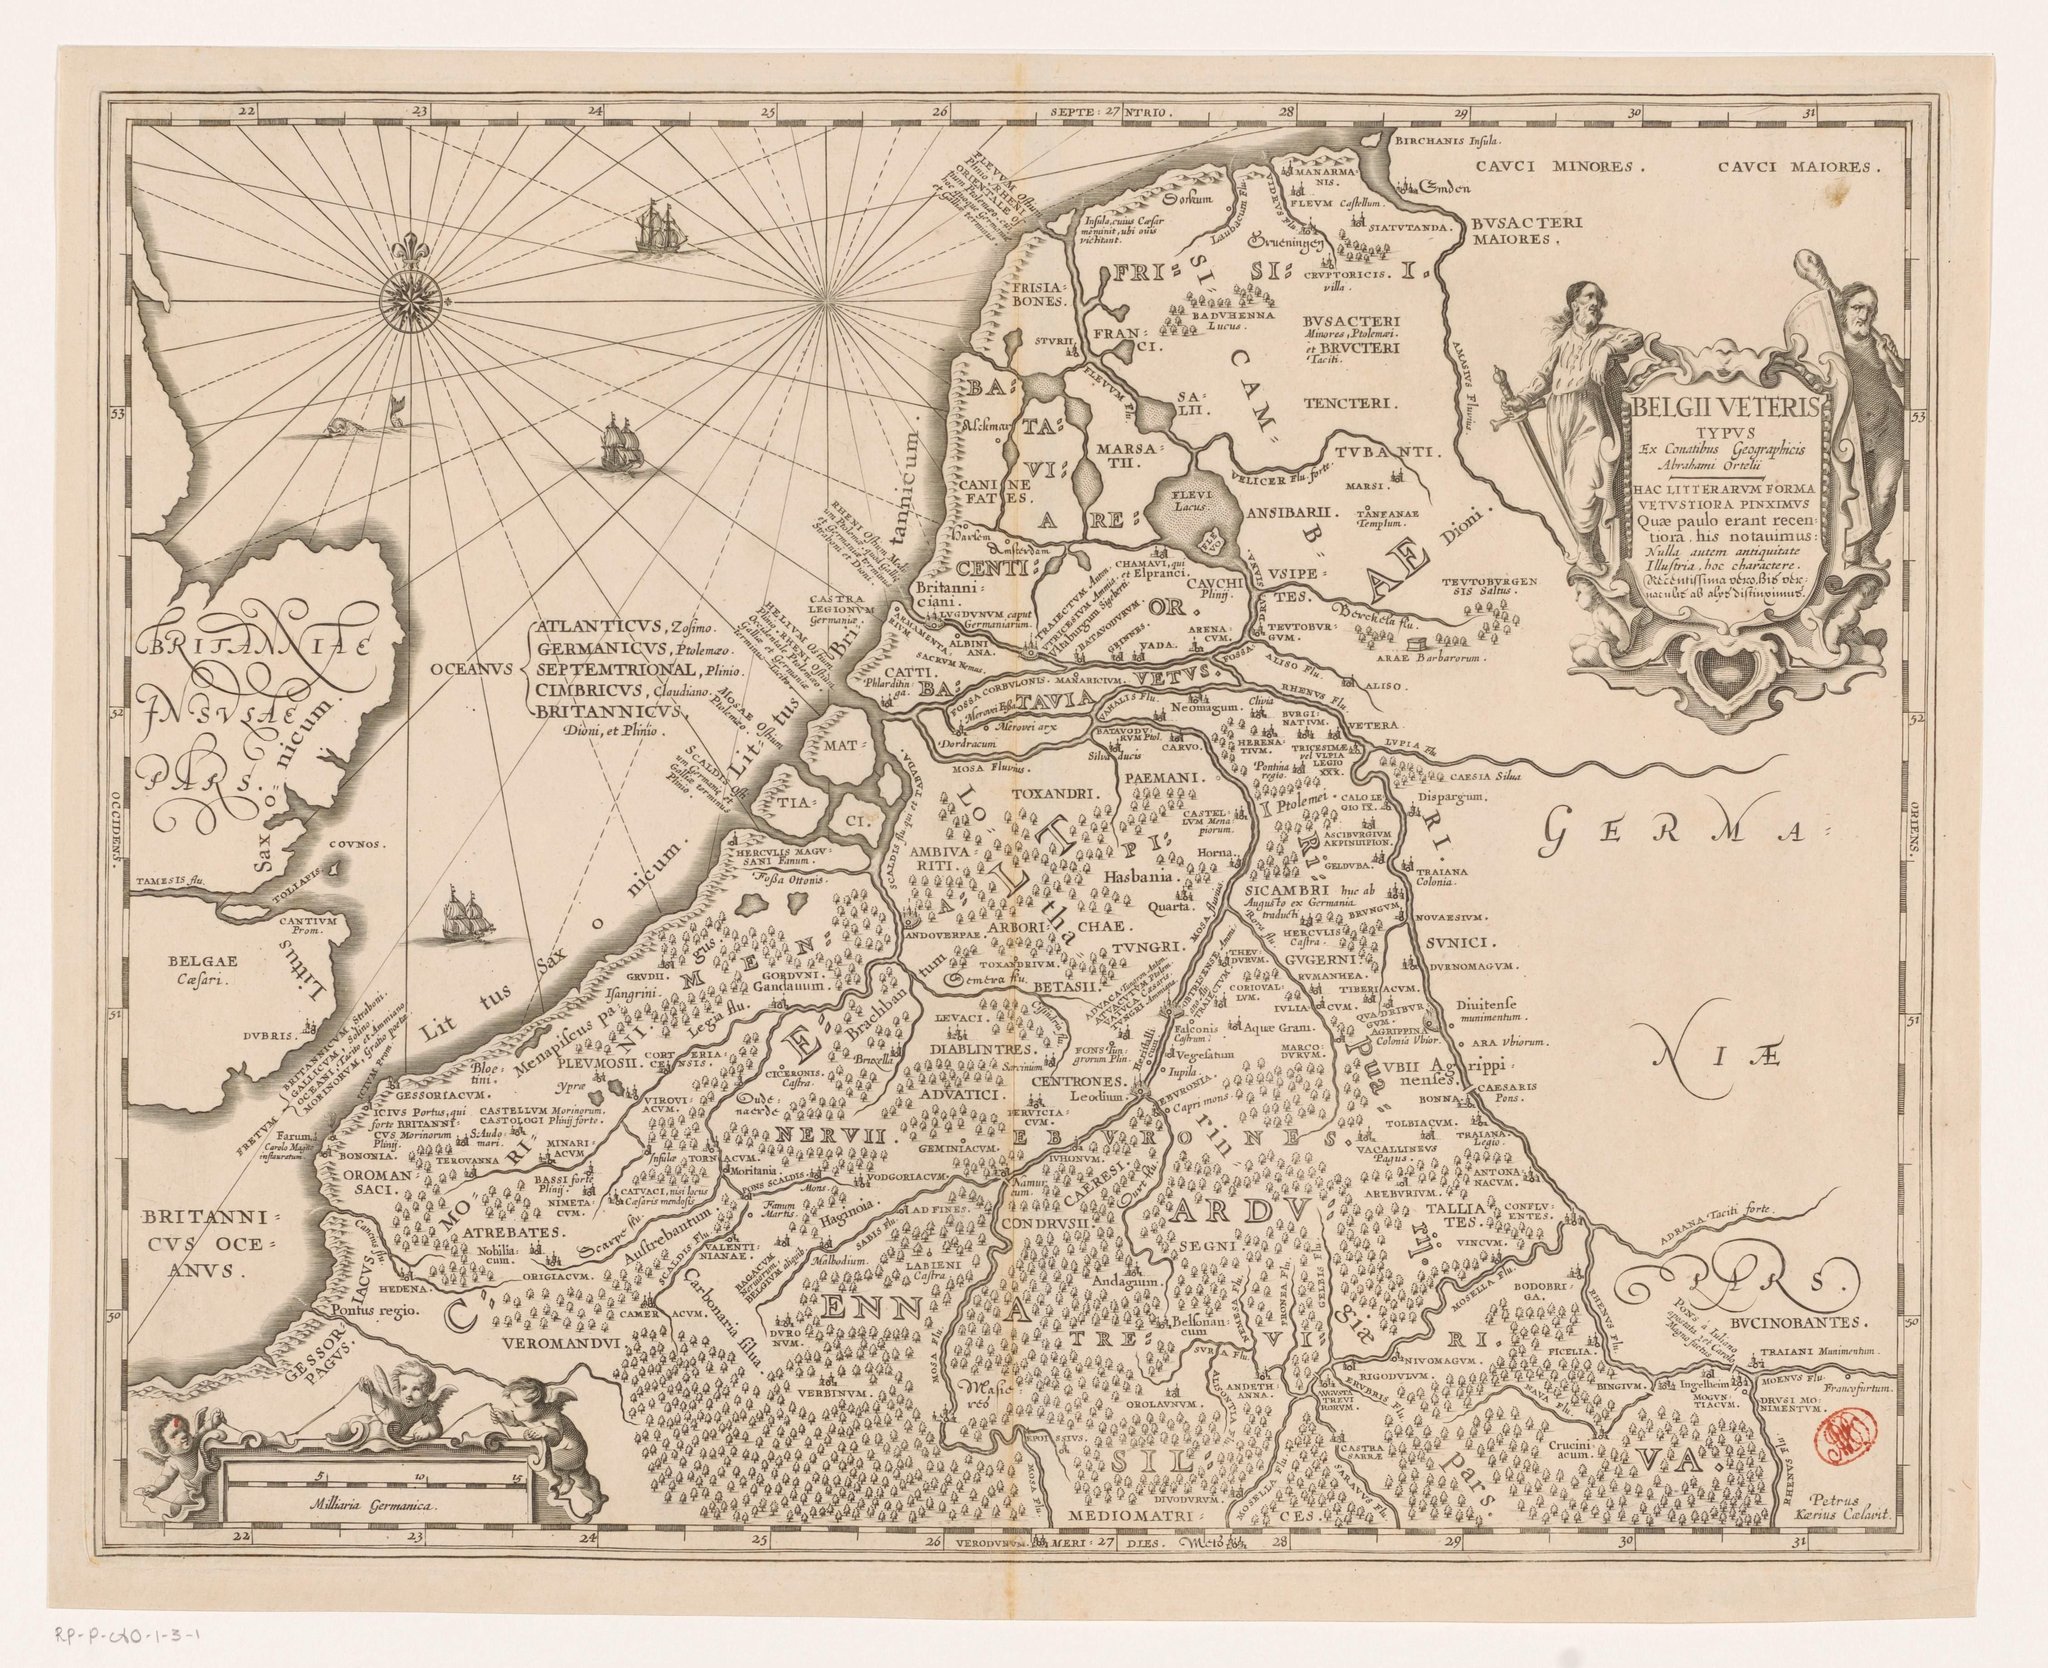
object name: map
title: Kaart van Nederland in de Romeinse tijd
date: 1636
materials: paper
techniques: engraving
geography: amsterdam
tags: maps of separate countries or regions, cupids: 'amores', 'amoretti', 'putti', netherlands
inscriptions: collector's mark: Lugt 195, collector's mark: Lugt 2228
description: Historische kaart van Nederland in de Romeinse tijd, met de Latijnse plaatsnamen. Rechtsboven de titelcartouche met aan weerszijden een Germaanse strijder. Linksonder een cartouche met schaalstok: 15 Milliaria Germanica. De kaart is voorzien van een gradenverdeling langs de randen.